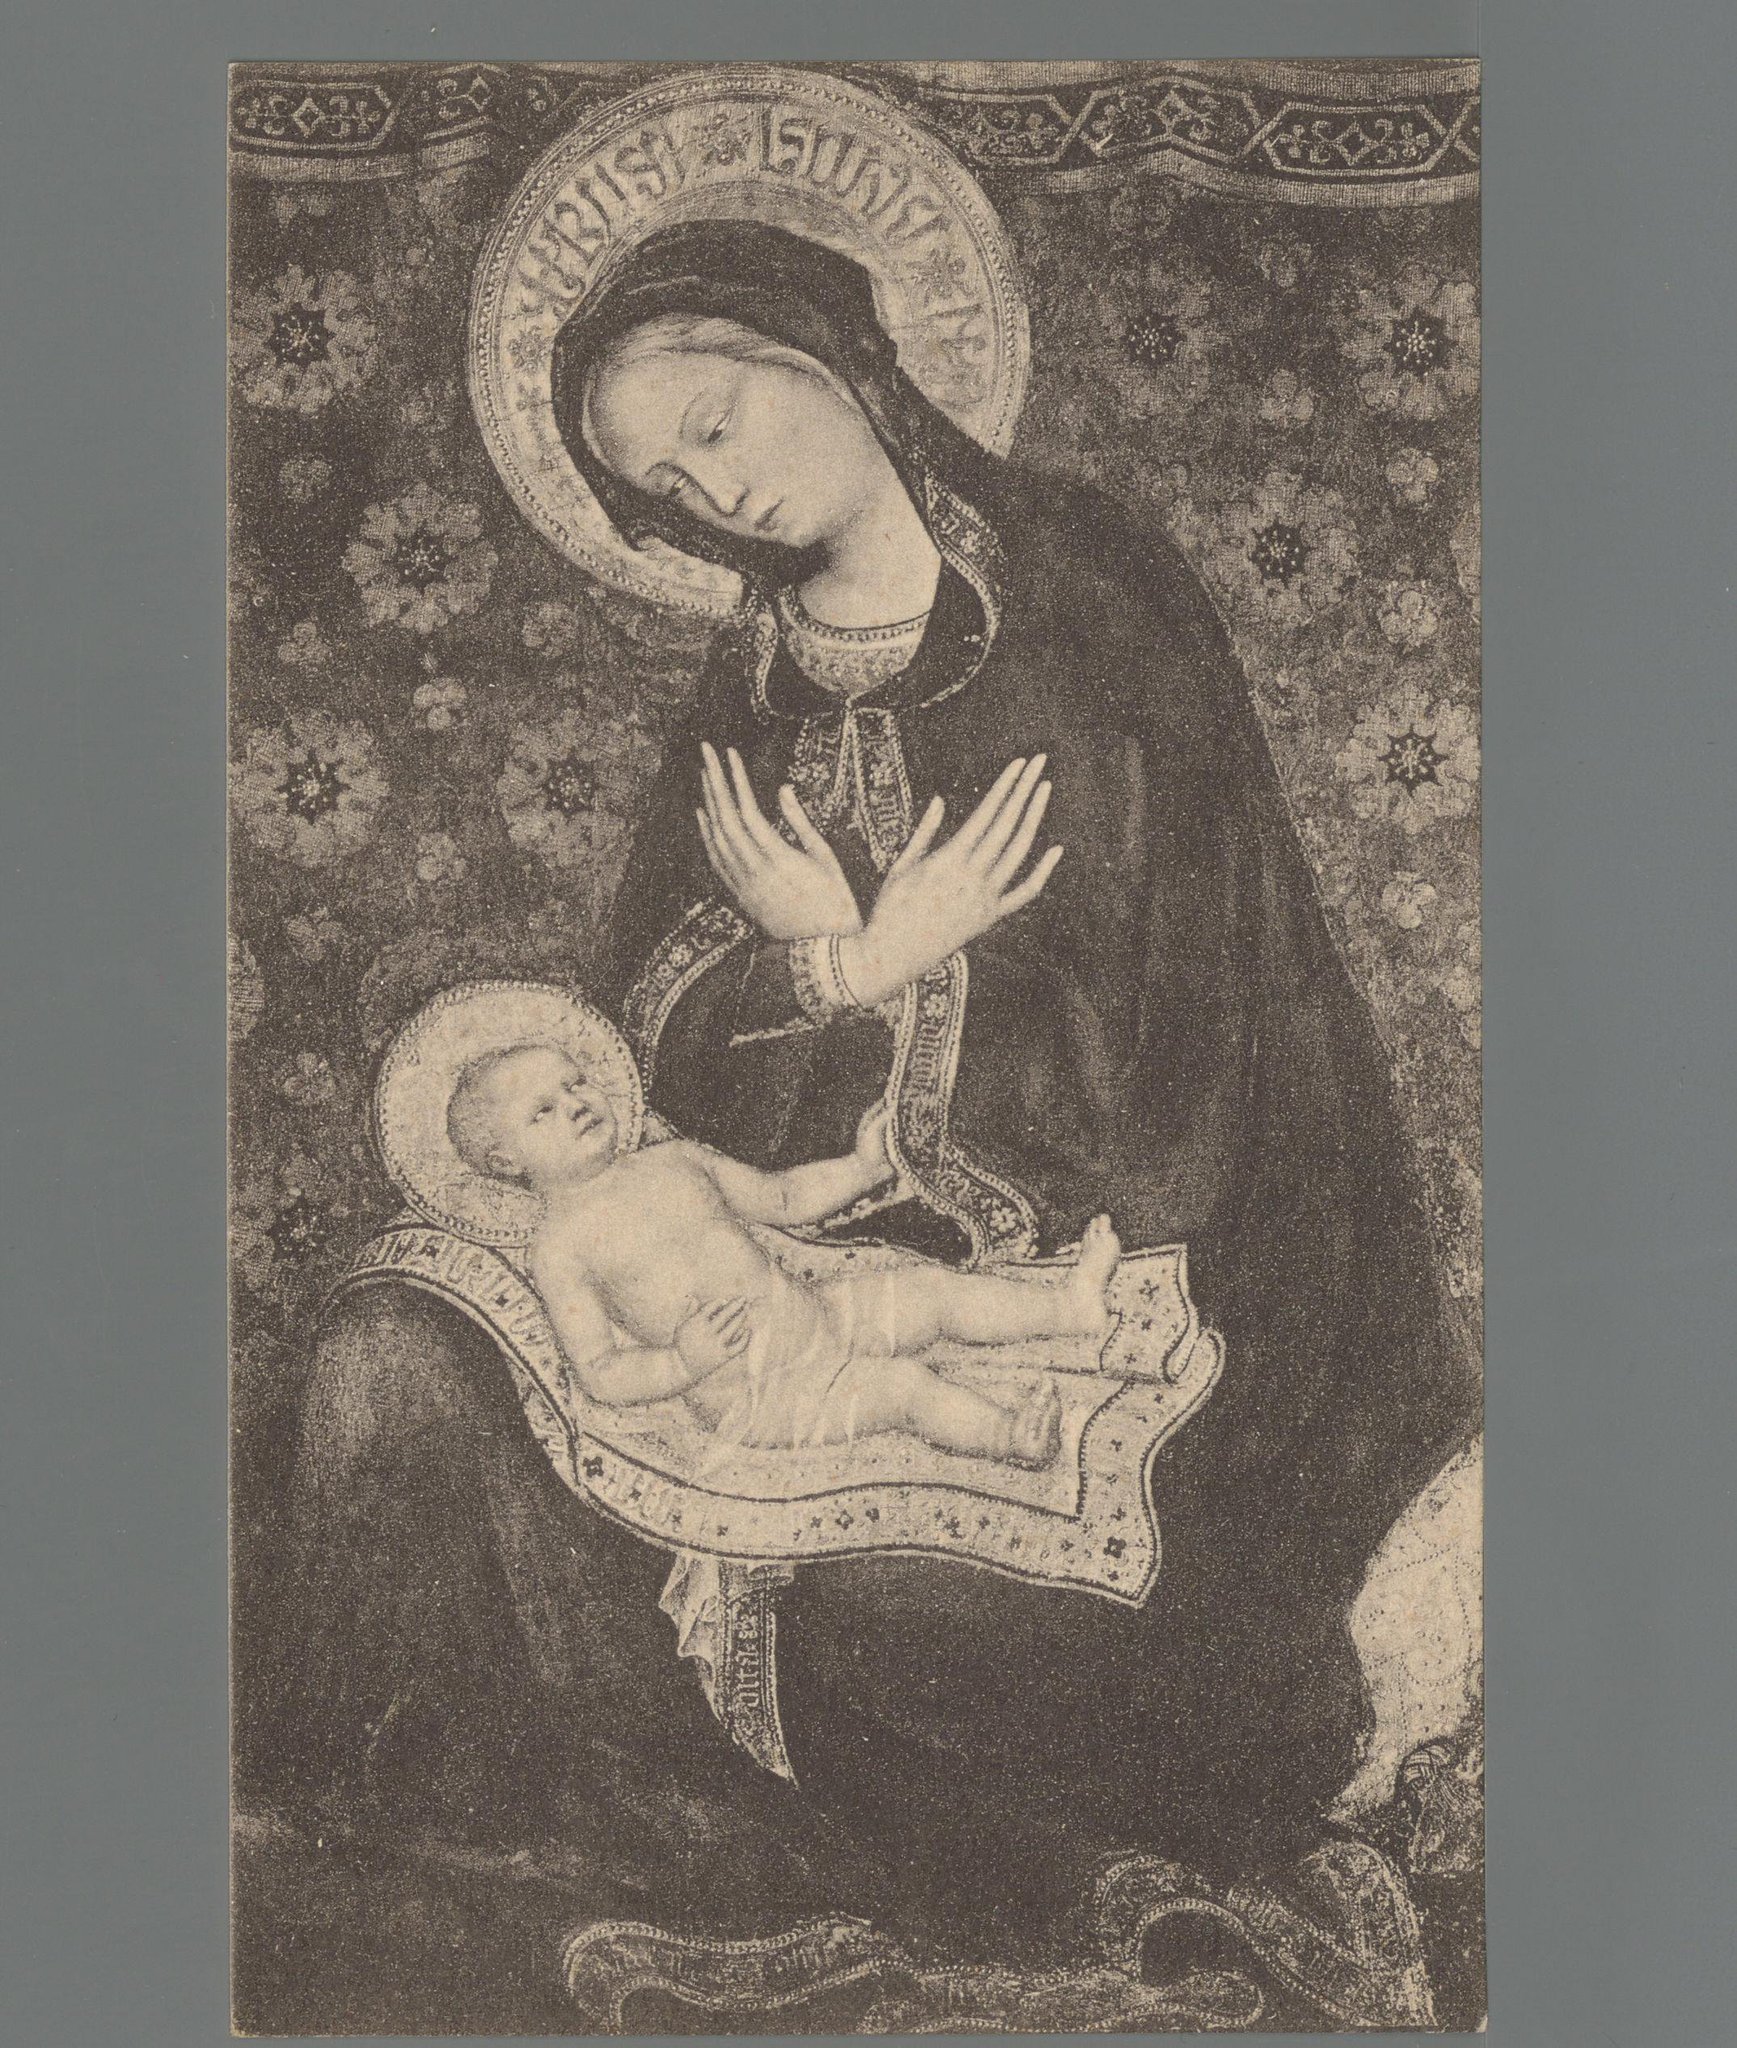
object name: reproduction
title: Pisa - Museo Civico. La Madonna che contempla il Divin Figlio (Gentile da Fabriano)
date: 1906-1930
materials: cardboard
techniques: photograph, writing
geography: pisa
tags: permanent exhibition, museum, picture, painting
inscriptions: collector's mark: ‘AFE v S’